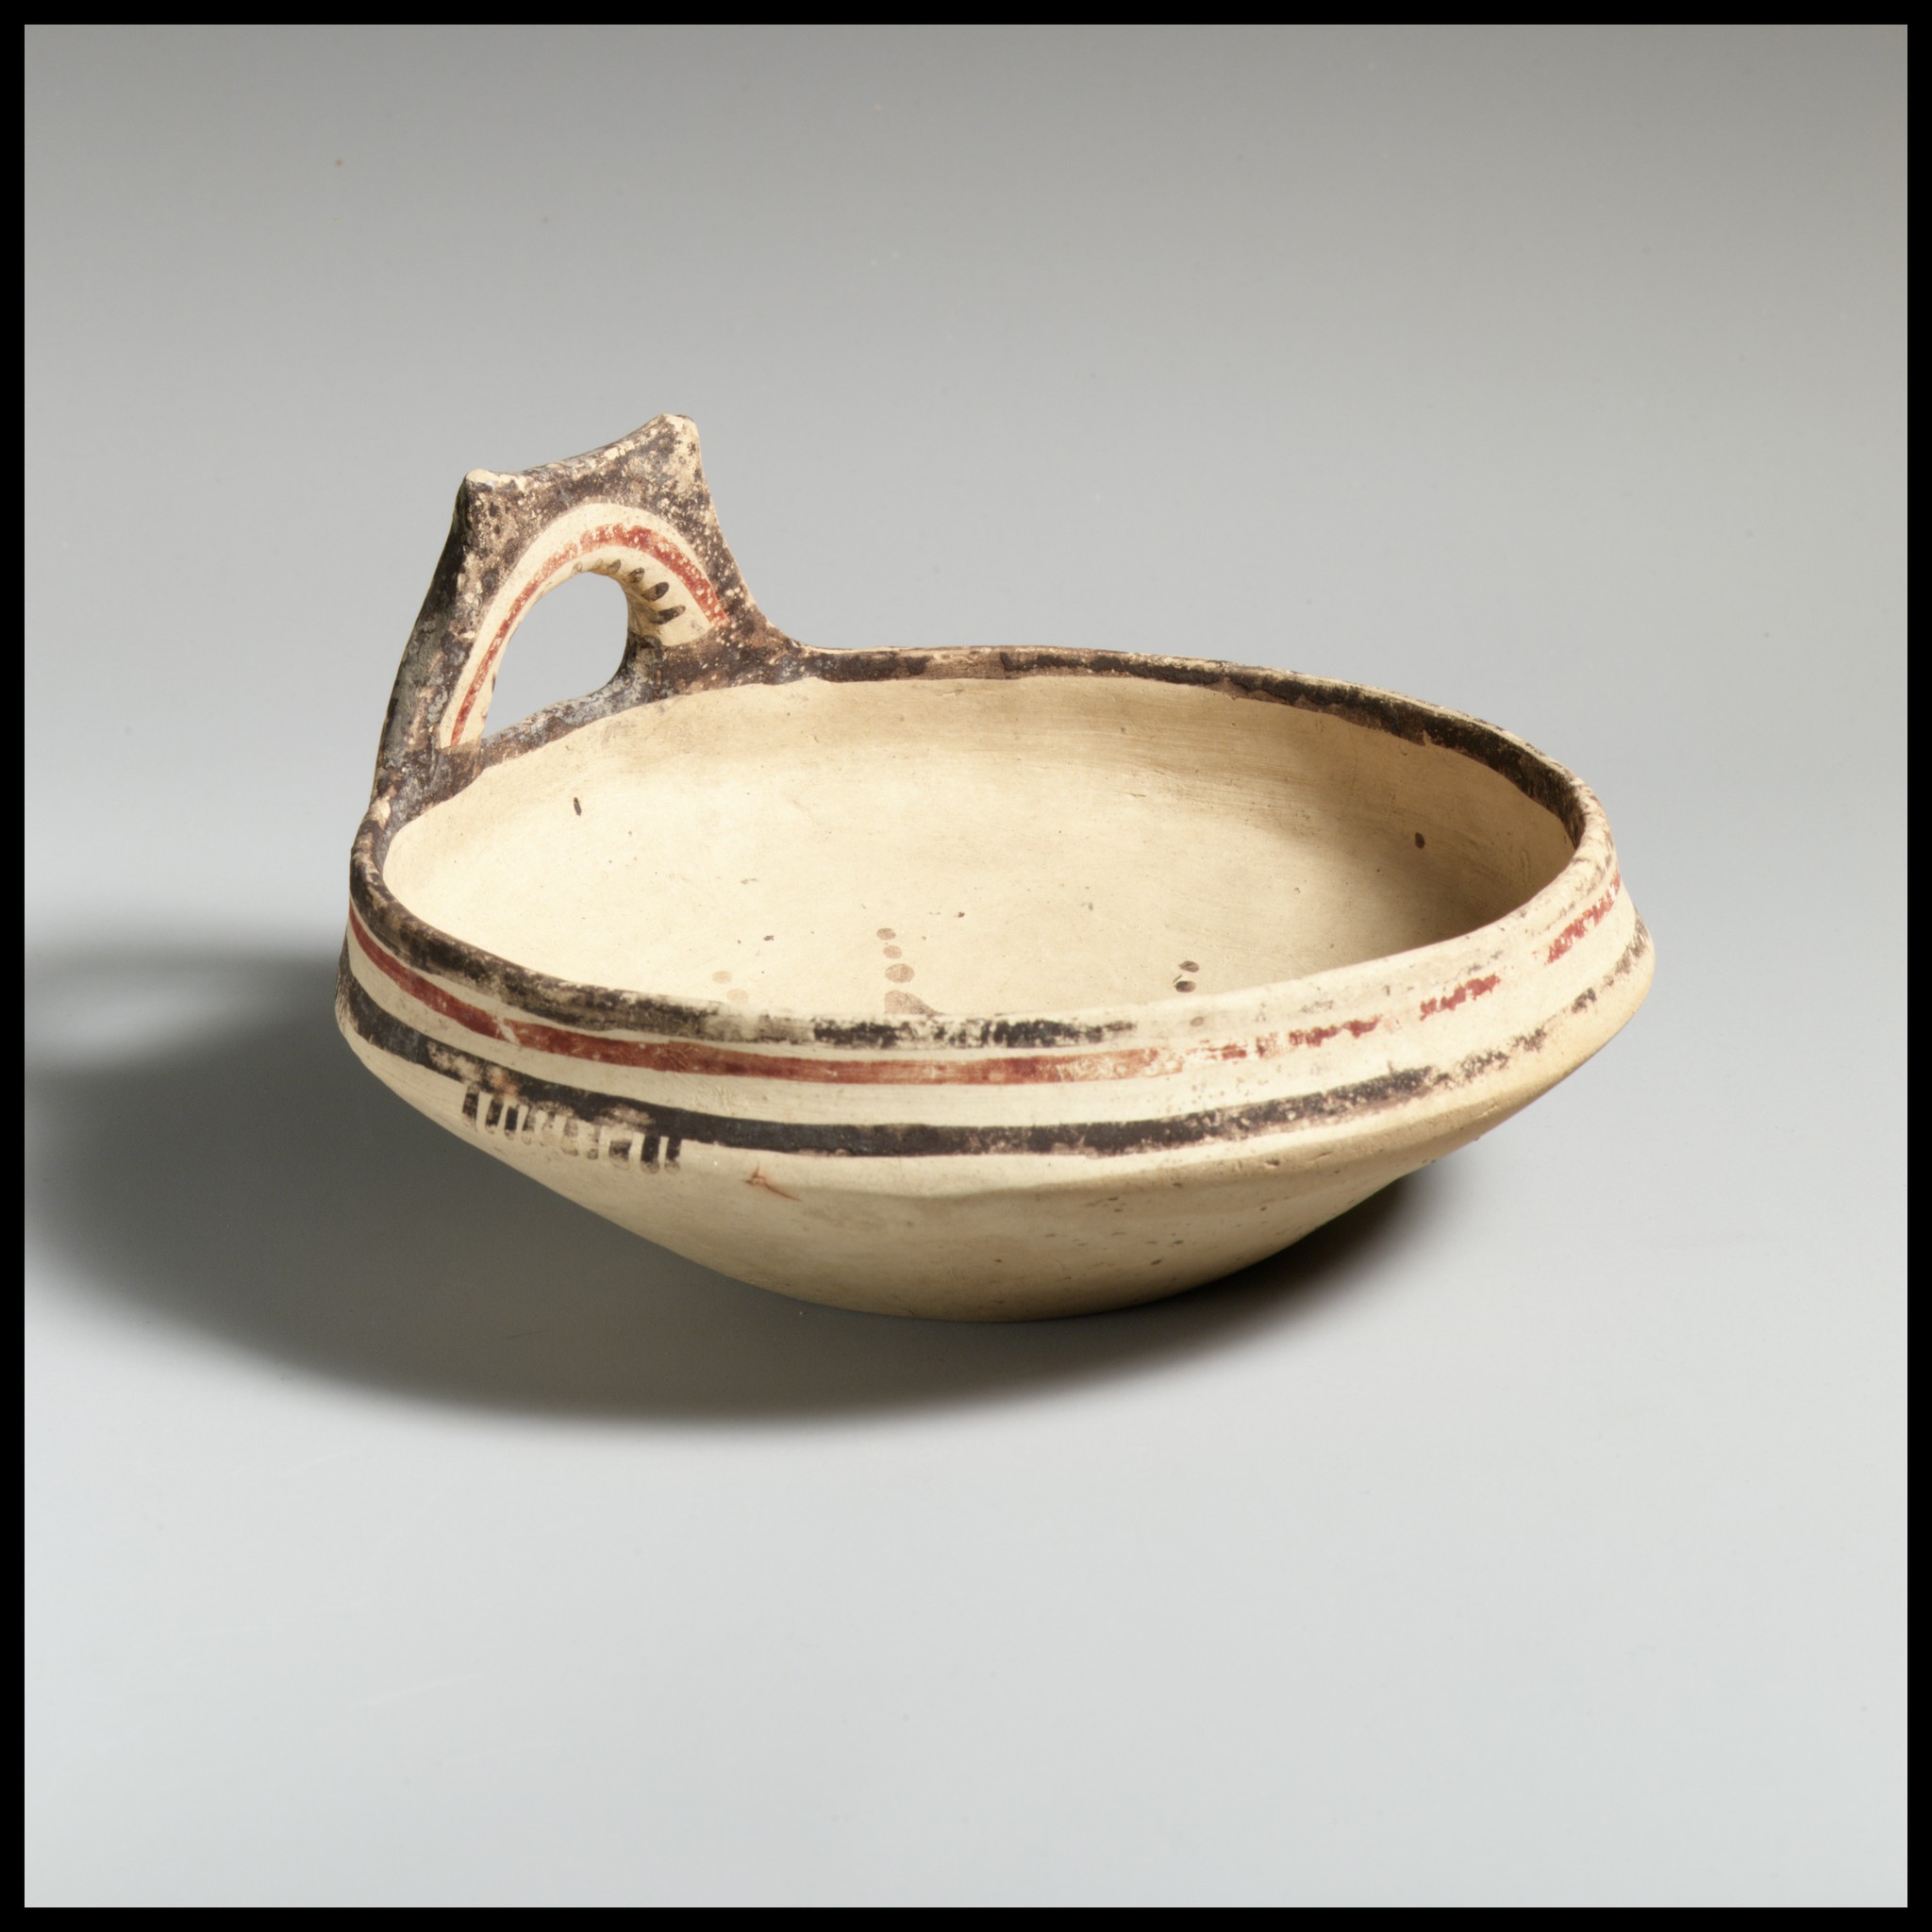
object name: bowl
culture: italic, daunian or south italian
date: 550-450 BCE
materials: terracotta